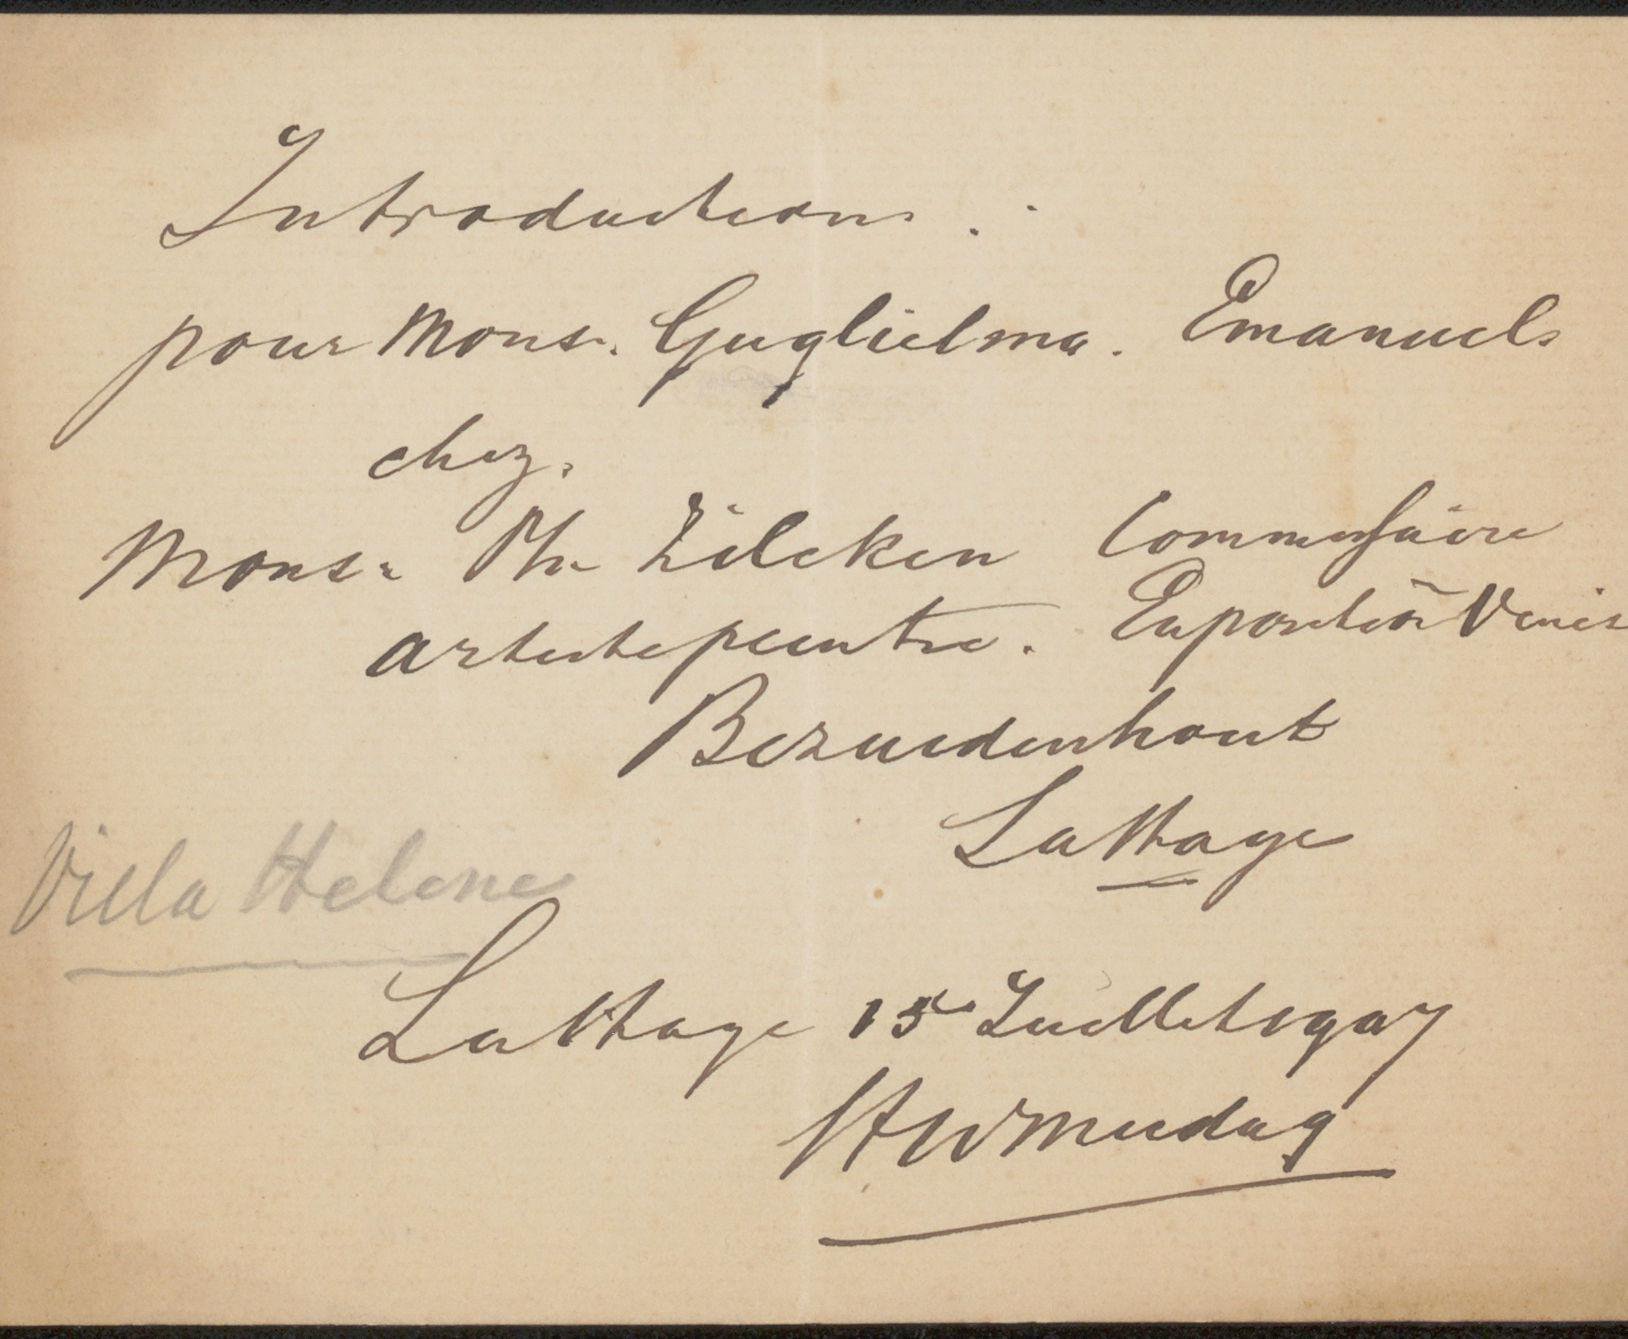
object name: letter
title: Brief aan Philip Zilcken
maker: hendrik willem mesdag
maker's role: draughtsman, painter, print maker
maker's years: 1831-1915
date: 1907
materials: ink, paper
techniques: pen, writing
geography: the hague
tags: naples, rome, philip zilcken, exhibition ~ art, venice